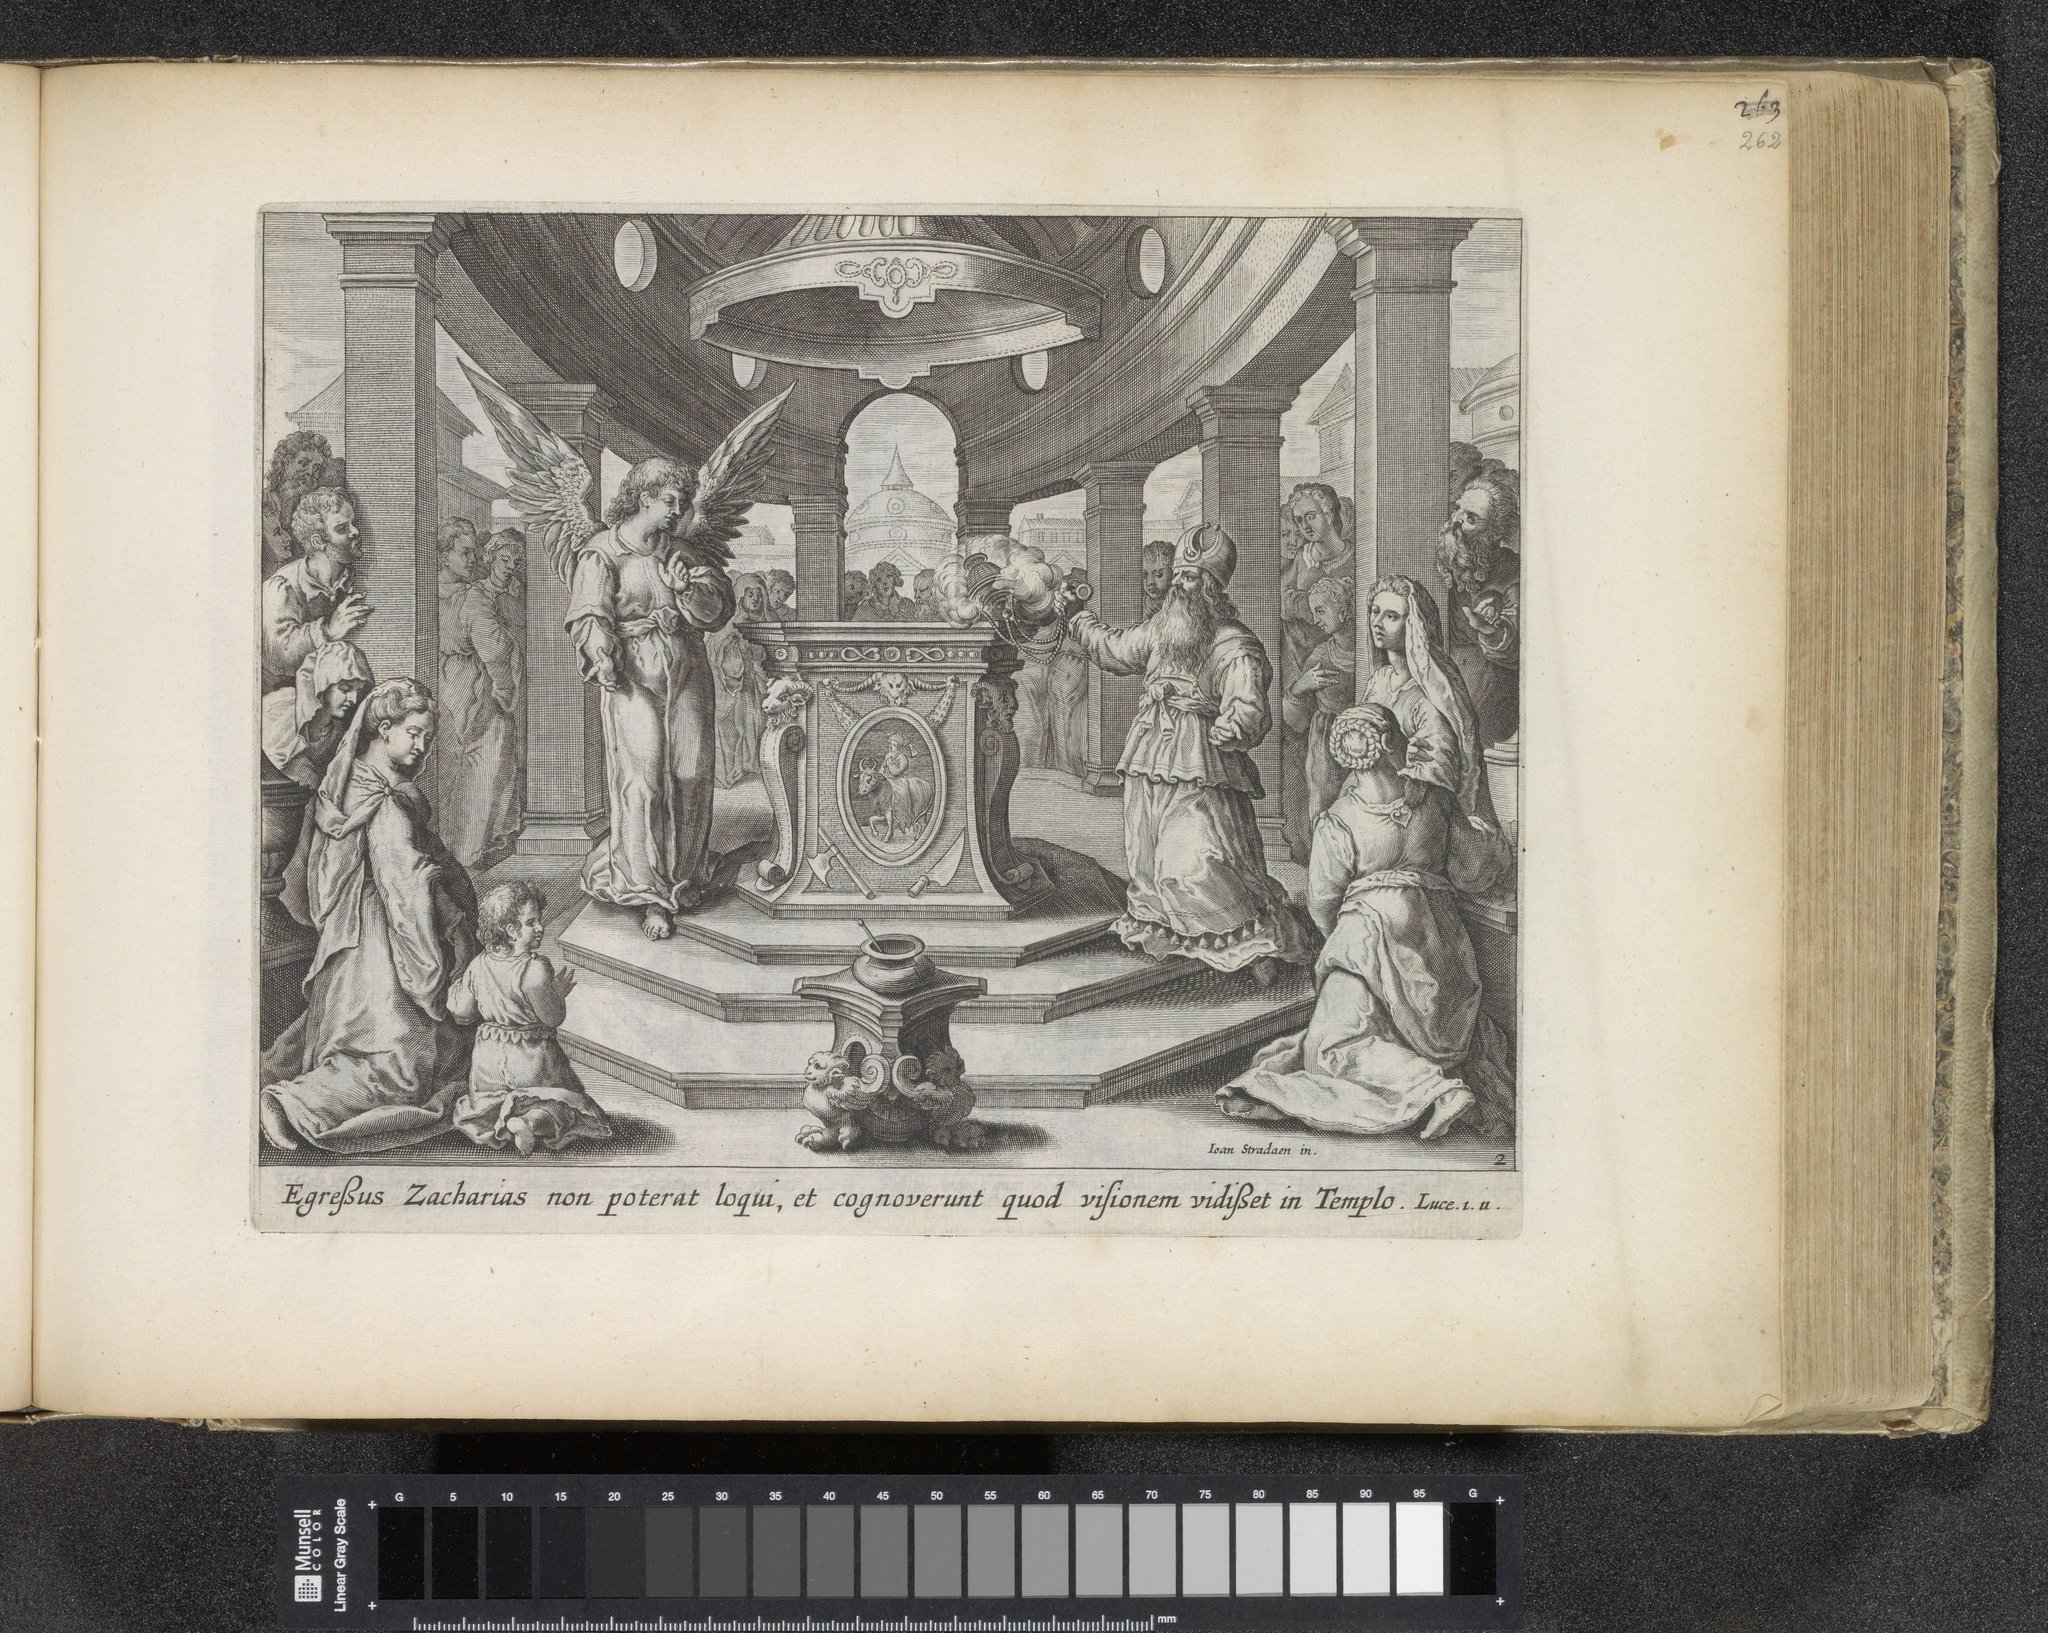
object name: album leaf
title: Theatrum Biblicum Hoc Est Historiae Sacrae Veteris et Novi Testamenti Tabulis Aeneis Expressae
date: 1638-1642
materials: paper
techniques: engraving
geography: amsterdam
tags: annunciation of the birth of john the baptist to zacharias: while he is offering incense in the temple an angel (gabriel) appears to him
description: Gezicht op een altaar in een ronde tempel. Zacharias knielt voor het altaar en zwaait met een wierookvat. Links staat een engel die de geboorte van Johannes de Doper aankondigt. Veel omstanders kijken naar de scène. Onder de voorstelling een verwijzing in het Latijn naar de Bijbeltekst in Luc. 1:11. Deze prent maakt deel uit van een album.